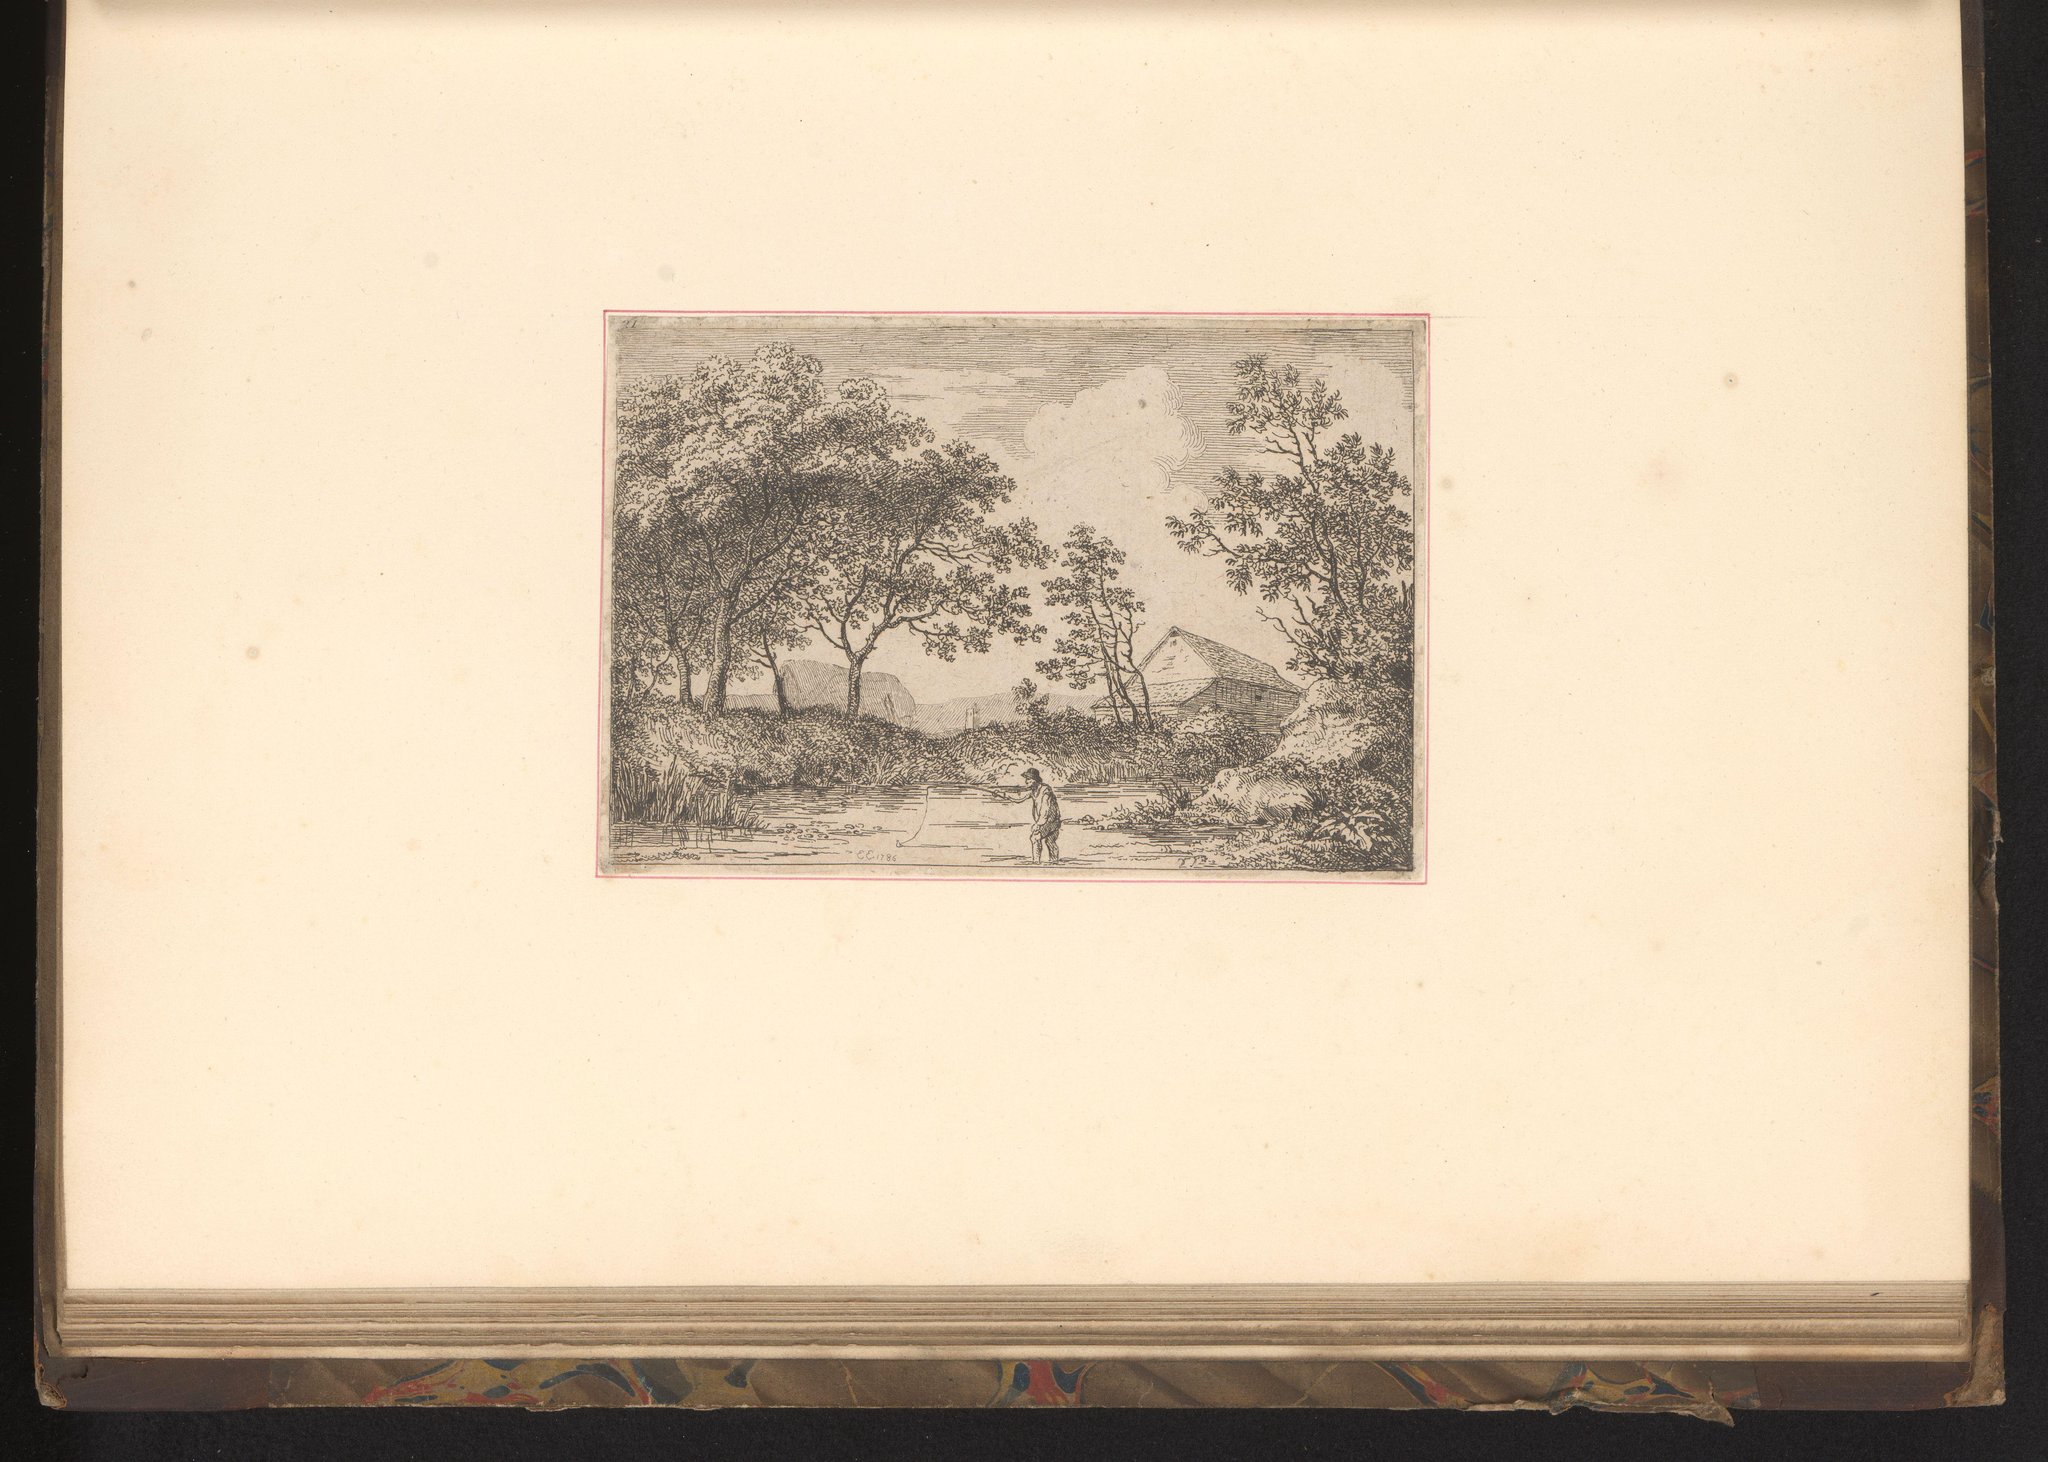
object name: album leaf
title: Landschap met een visser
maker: edward edwards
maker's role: painter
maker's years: 1738-1806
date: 1748-1806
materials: paper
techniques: etching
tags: landscapes (+ landscape with figures, staffage), fisherman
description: Prent maakt deel uit van een serie van 51 prenten, bestaande uit twee delen met landschappen (36 prenten) en figuren en portretten (15 prenten), voor het eerst uitgegeven in Londen in 1790.